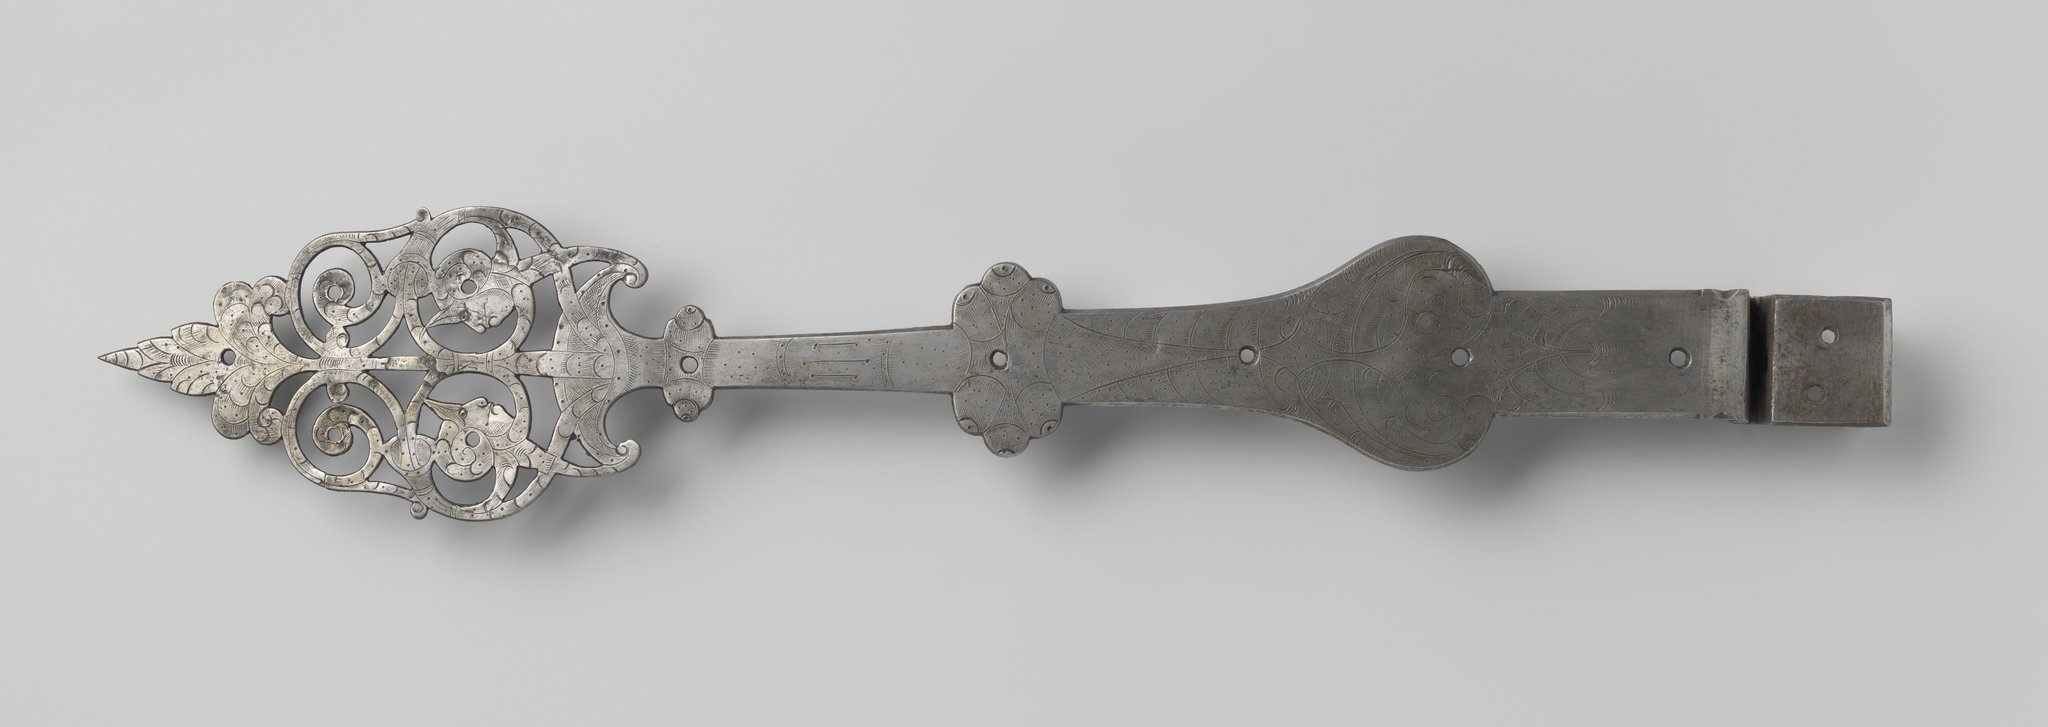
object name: door fitting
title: Deurhengsel van vertind ijzer, versierd met graveringen en narrenkoppen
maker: Anonymous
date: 1600-1700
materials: iron, tin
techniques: engraving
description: Deurhengsel van vertind ijzer versierd met graveringen. Het beslag is vanaf het scharnier als volgt: een balustervormig begin, overgaand in een smal, recht stuk waaruit naar het einde toe enkele bladmotieven ontspringen, die als voluten omkrullen. In het midden daarvan kijken twee narrenkoppen elkaar aan. Het geheel eindigt in een puntig blad.